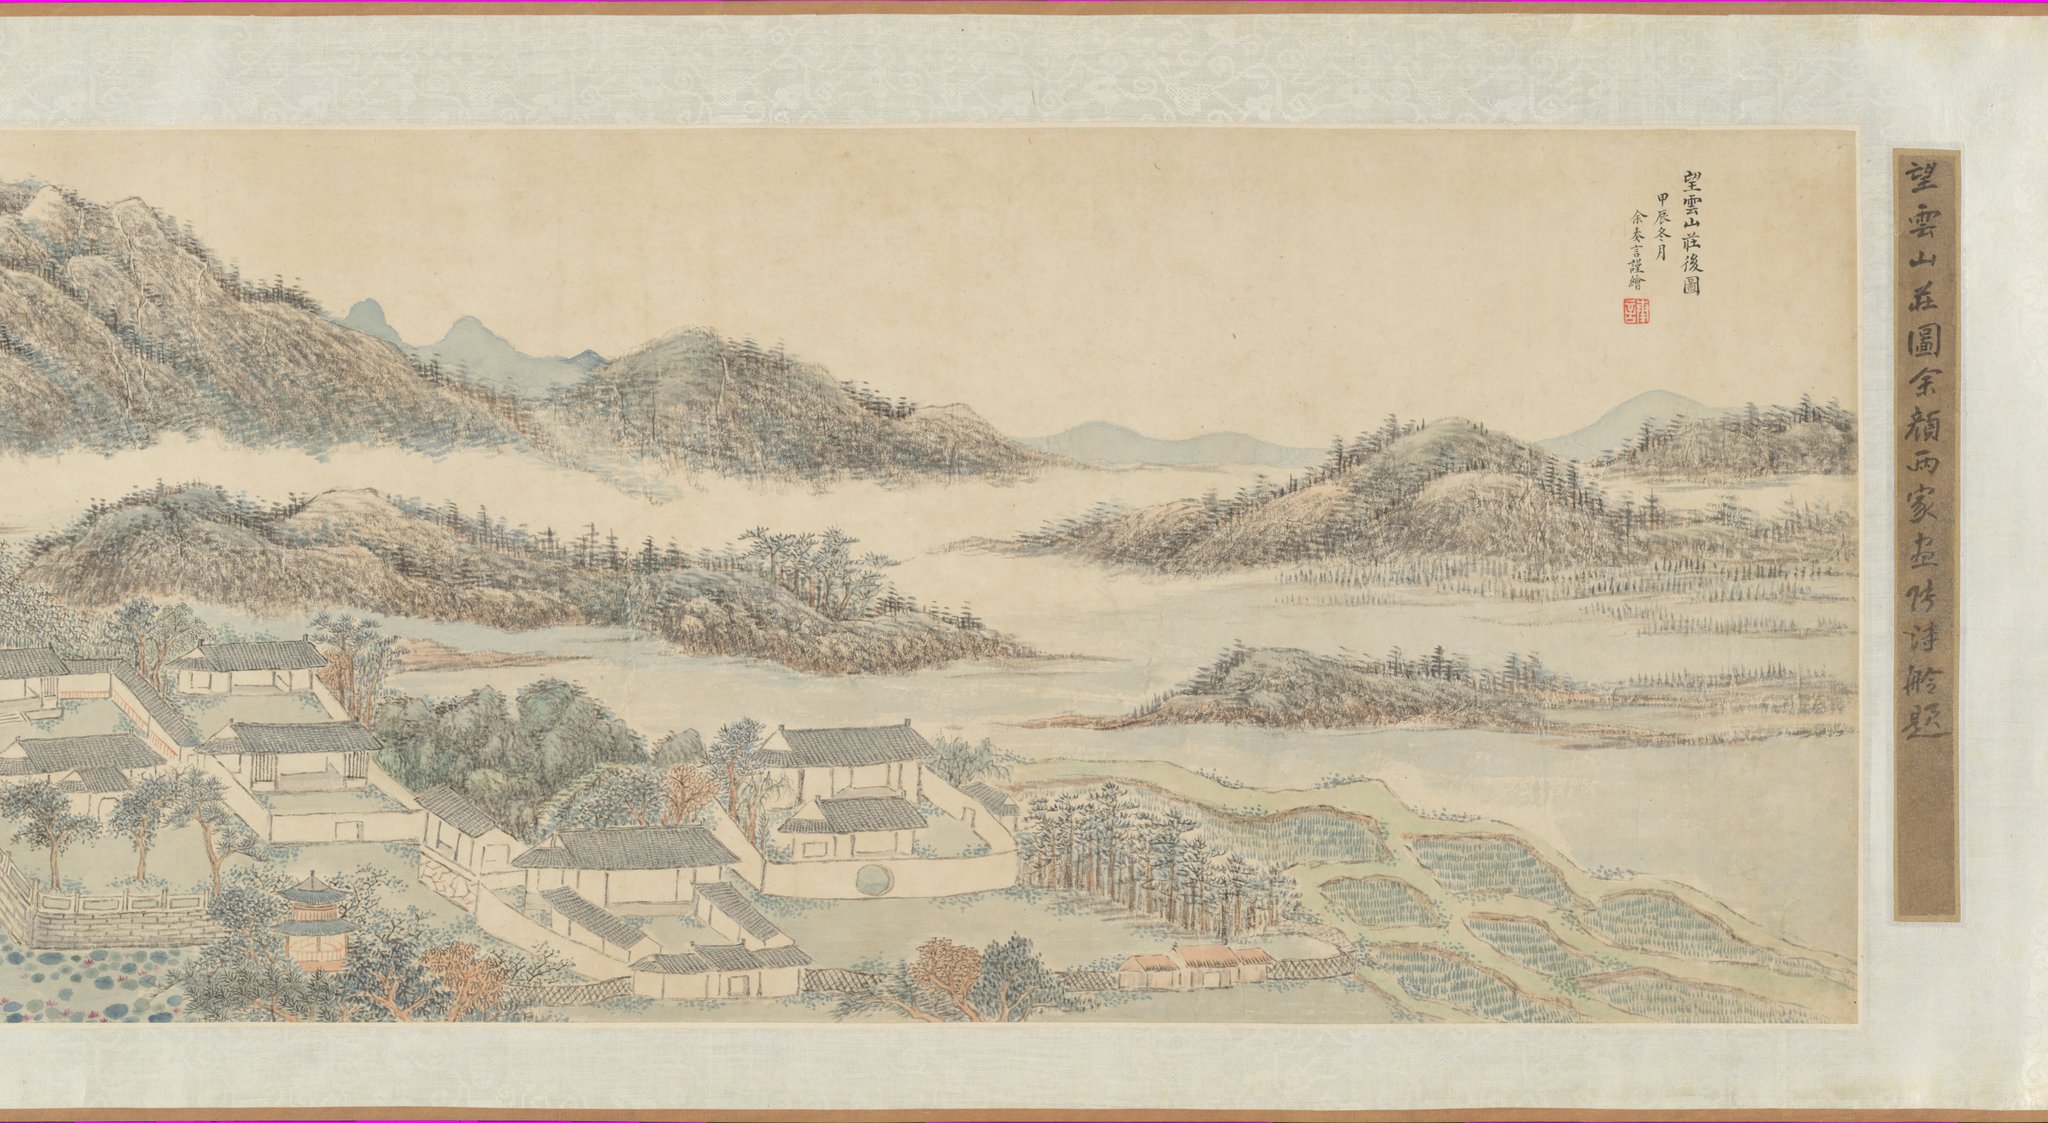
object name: handscroll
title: Rear View of the Mountain Villa for Watching Clouds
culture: chinese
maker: yu zouyan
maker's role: artist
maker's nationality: chinese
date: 1844-1845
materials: ink, paper